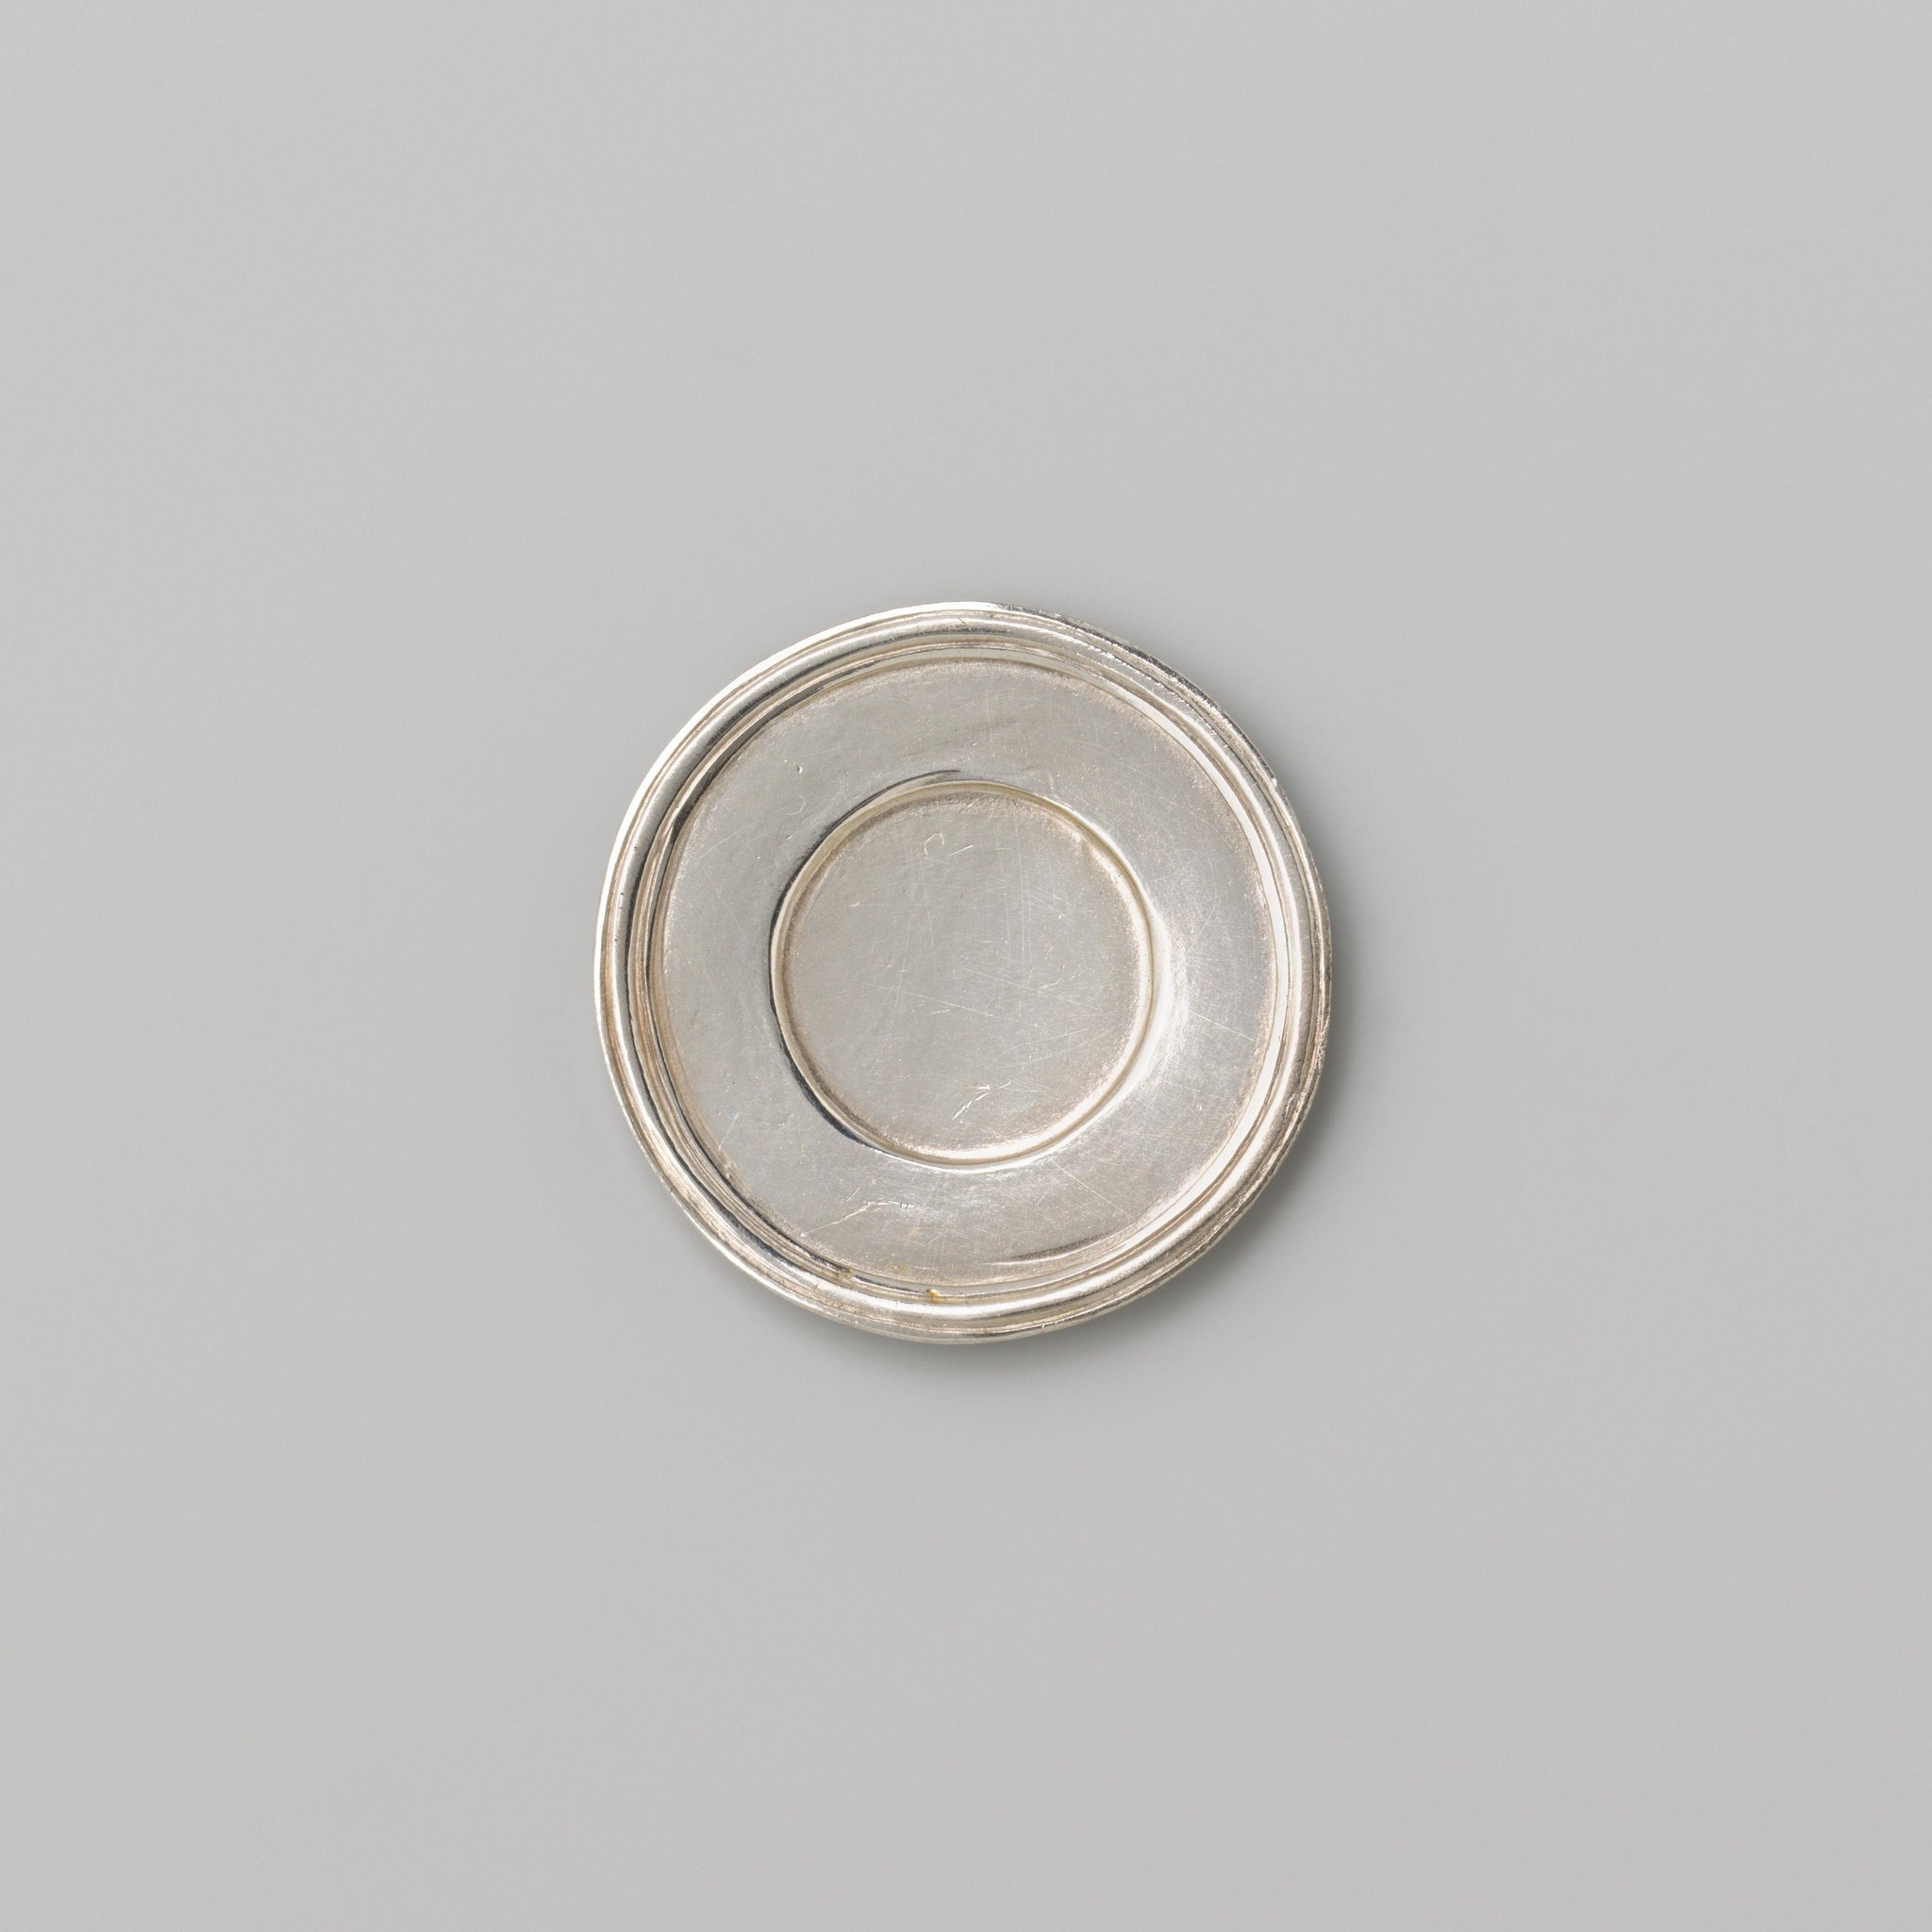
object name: platter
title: Zilverkleurige schoteltje met brede platte geprofileerde rand.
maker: Anonymous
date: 1700-1710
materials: copper alloy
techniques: silvering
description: Zilverkleurige schotel met brede, platte geprofileerde rand.